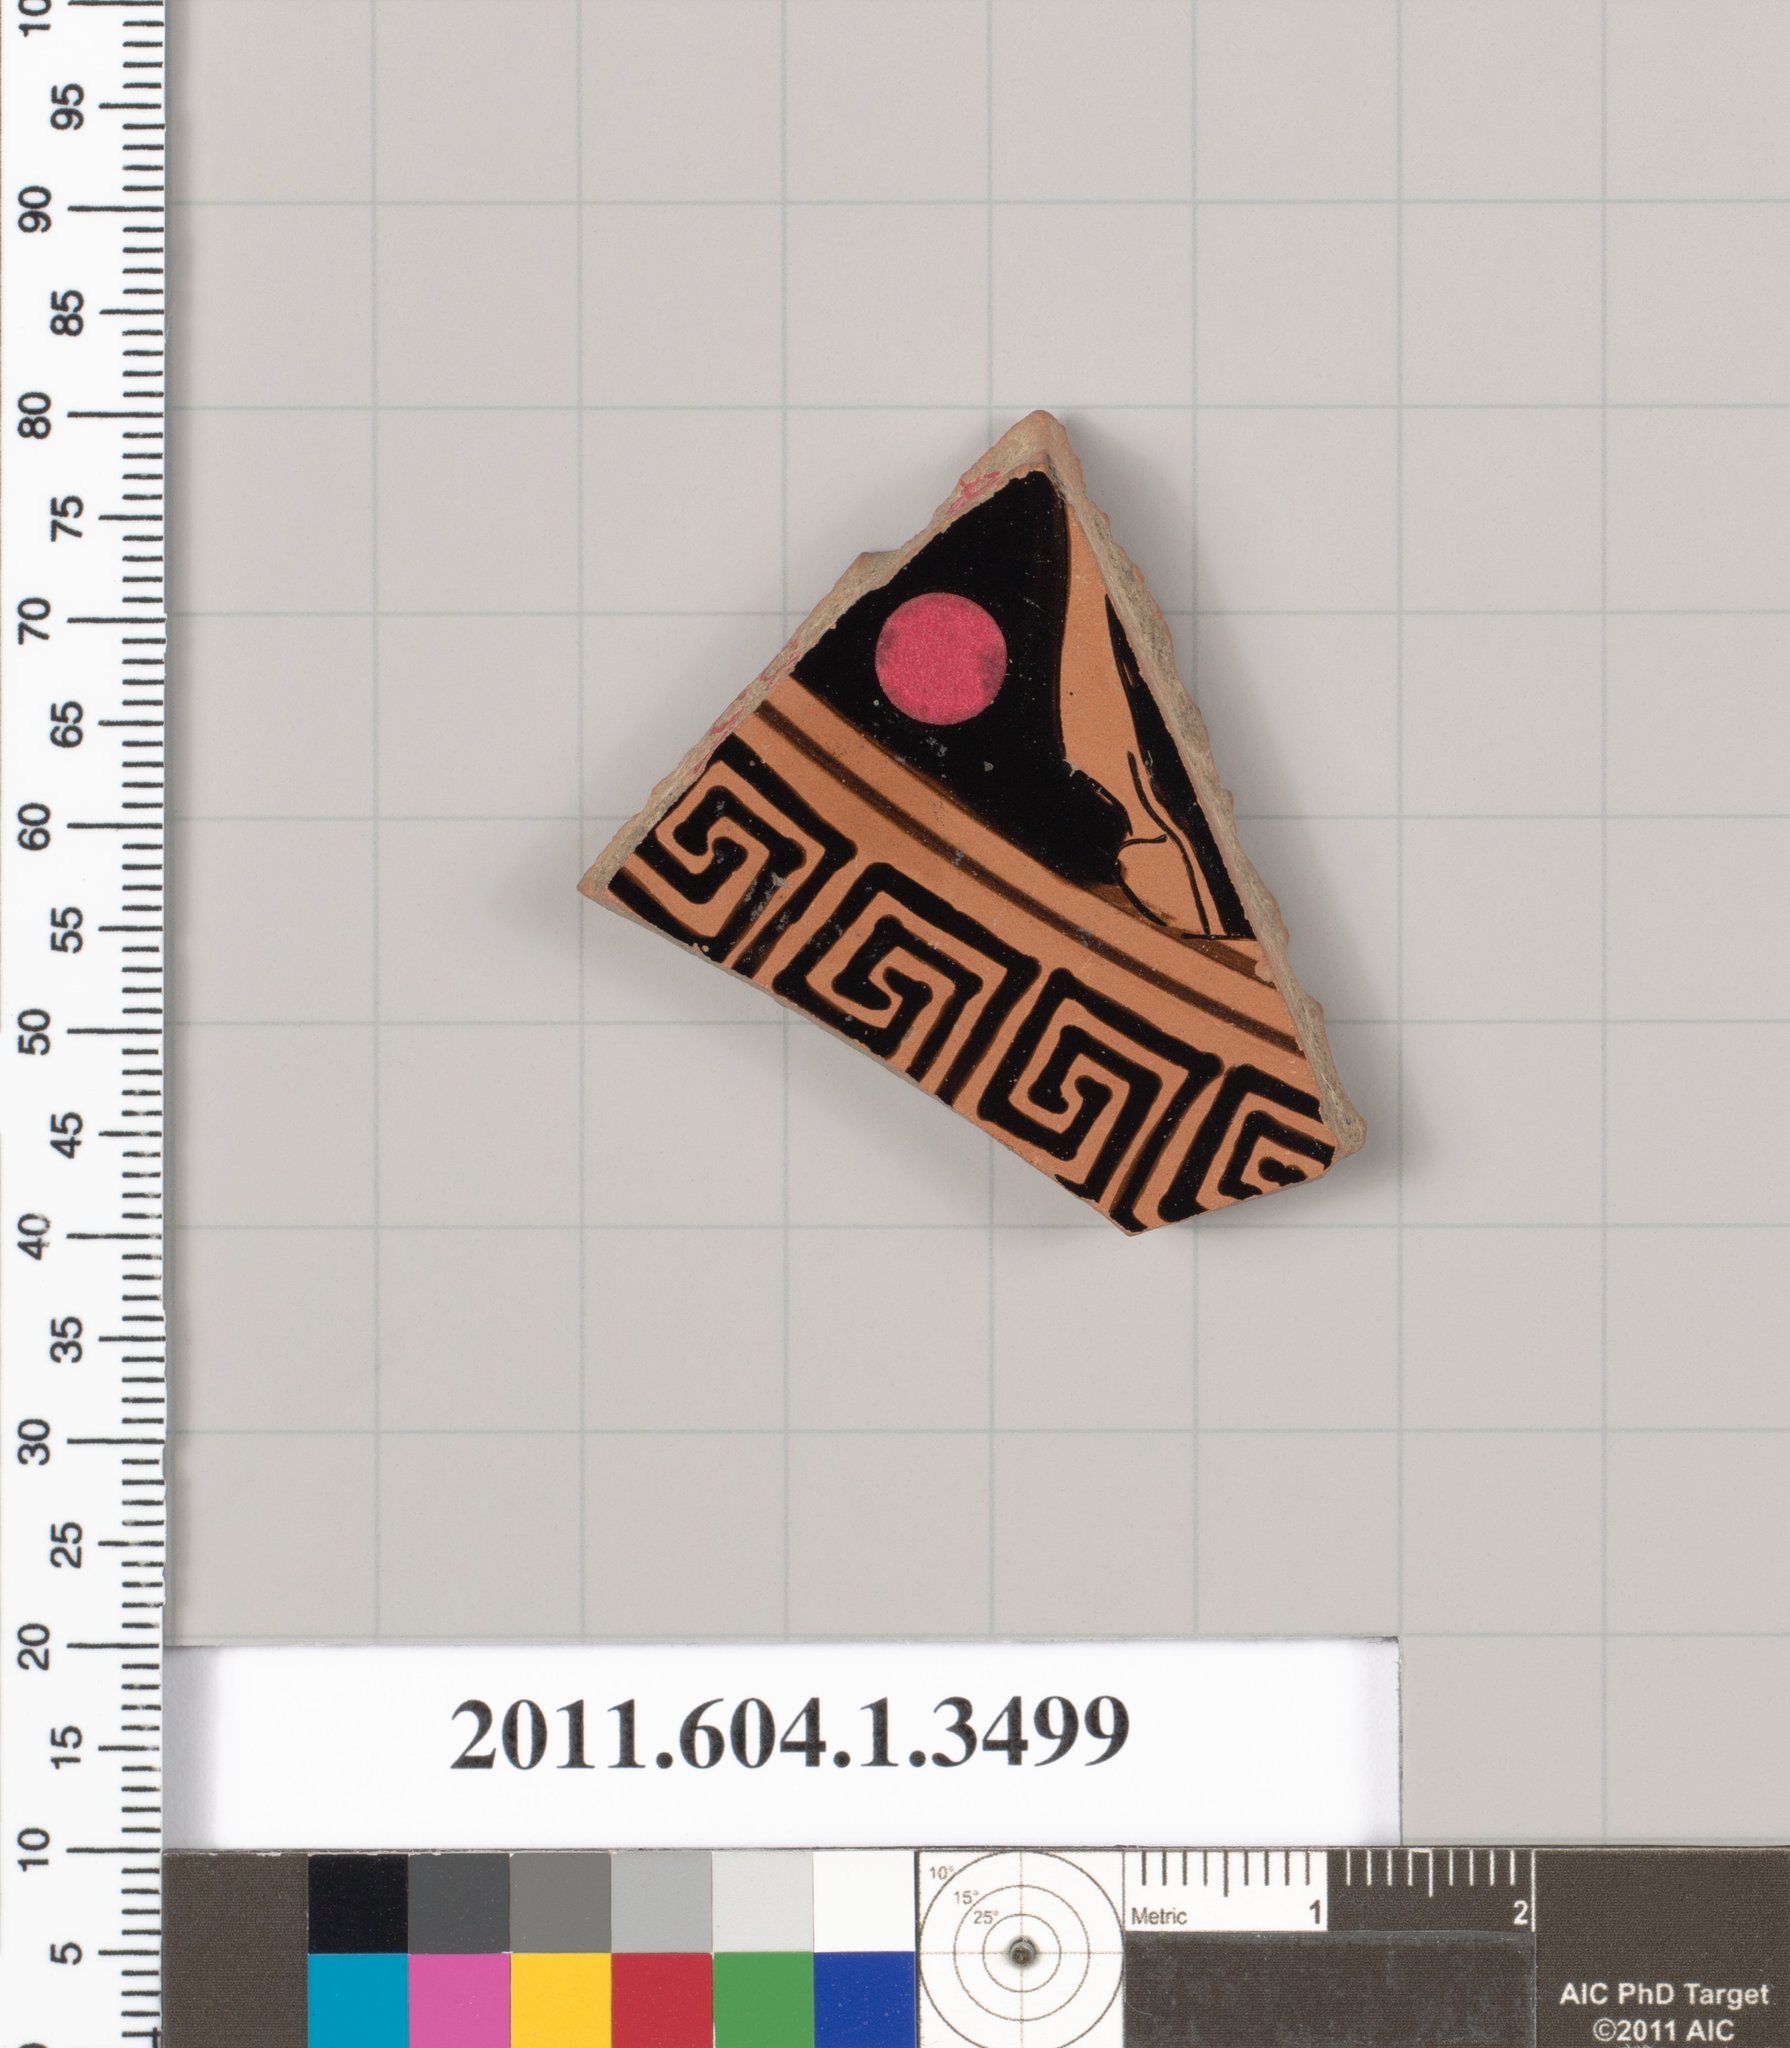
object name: kylix fragment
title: Terracotta fragment of a kylix (drinking cup)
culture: greek, attic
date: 490-480 BCE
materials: terracotta